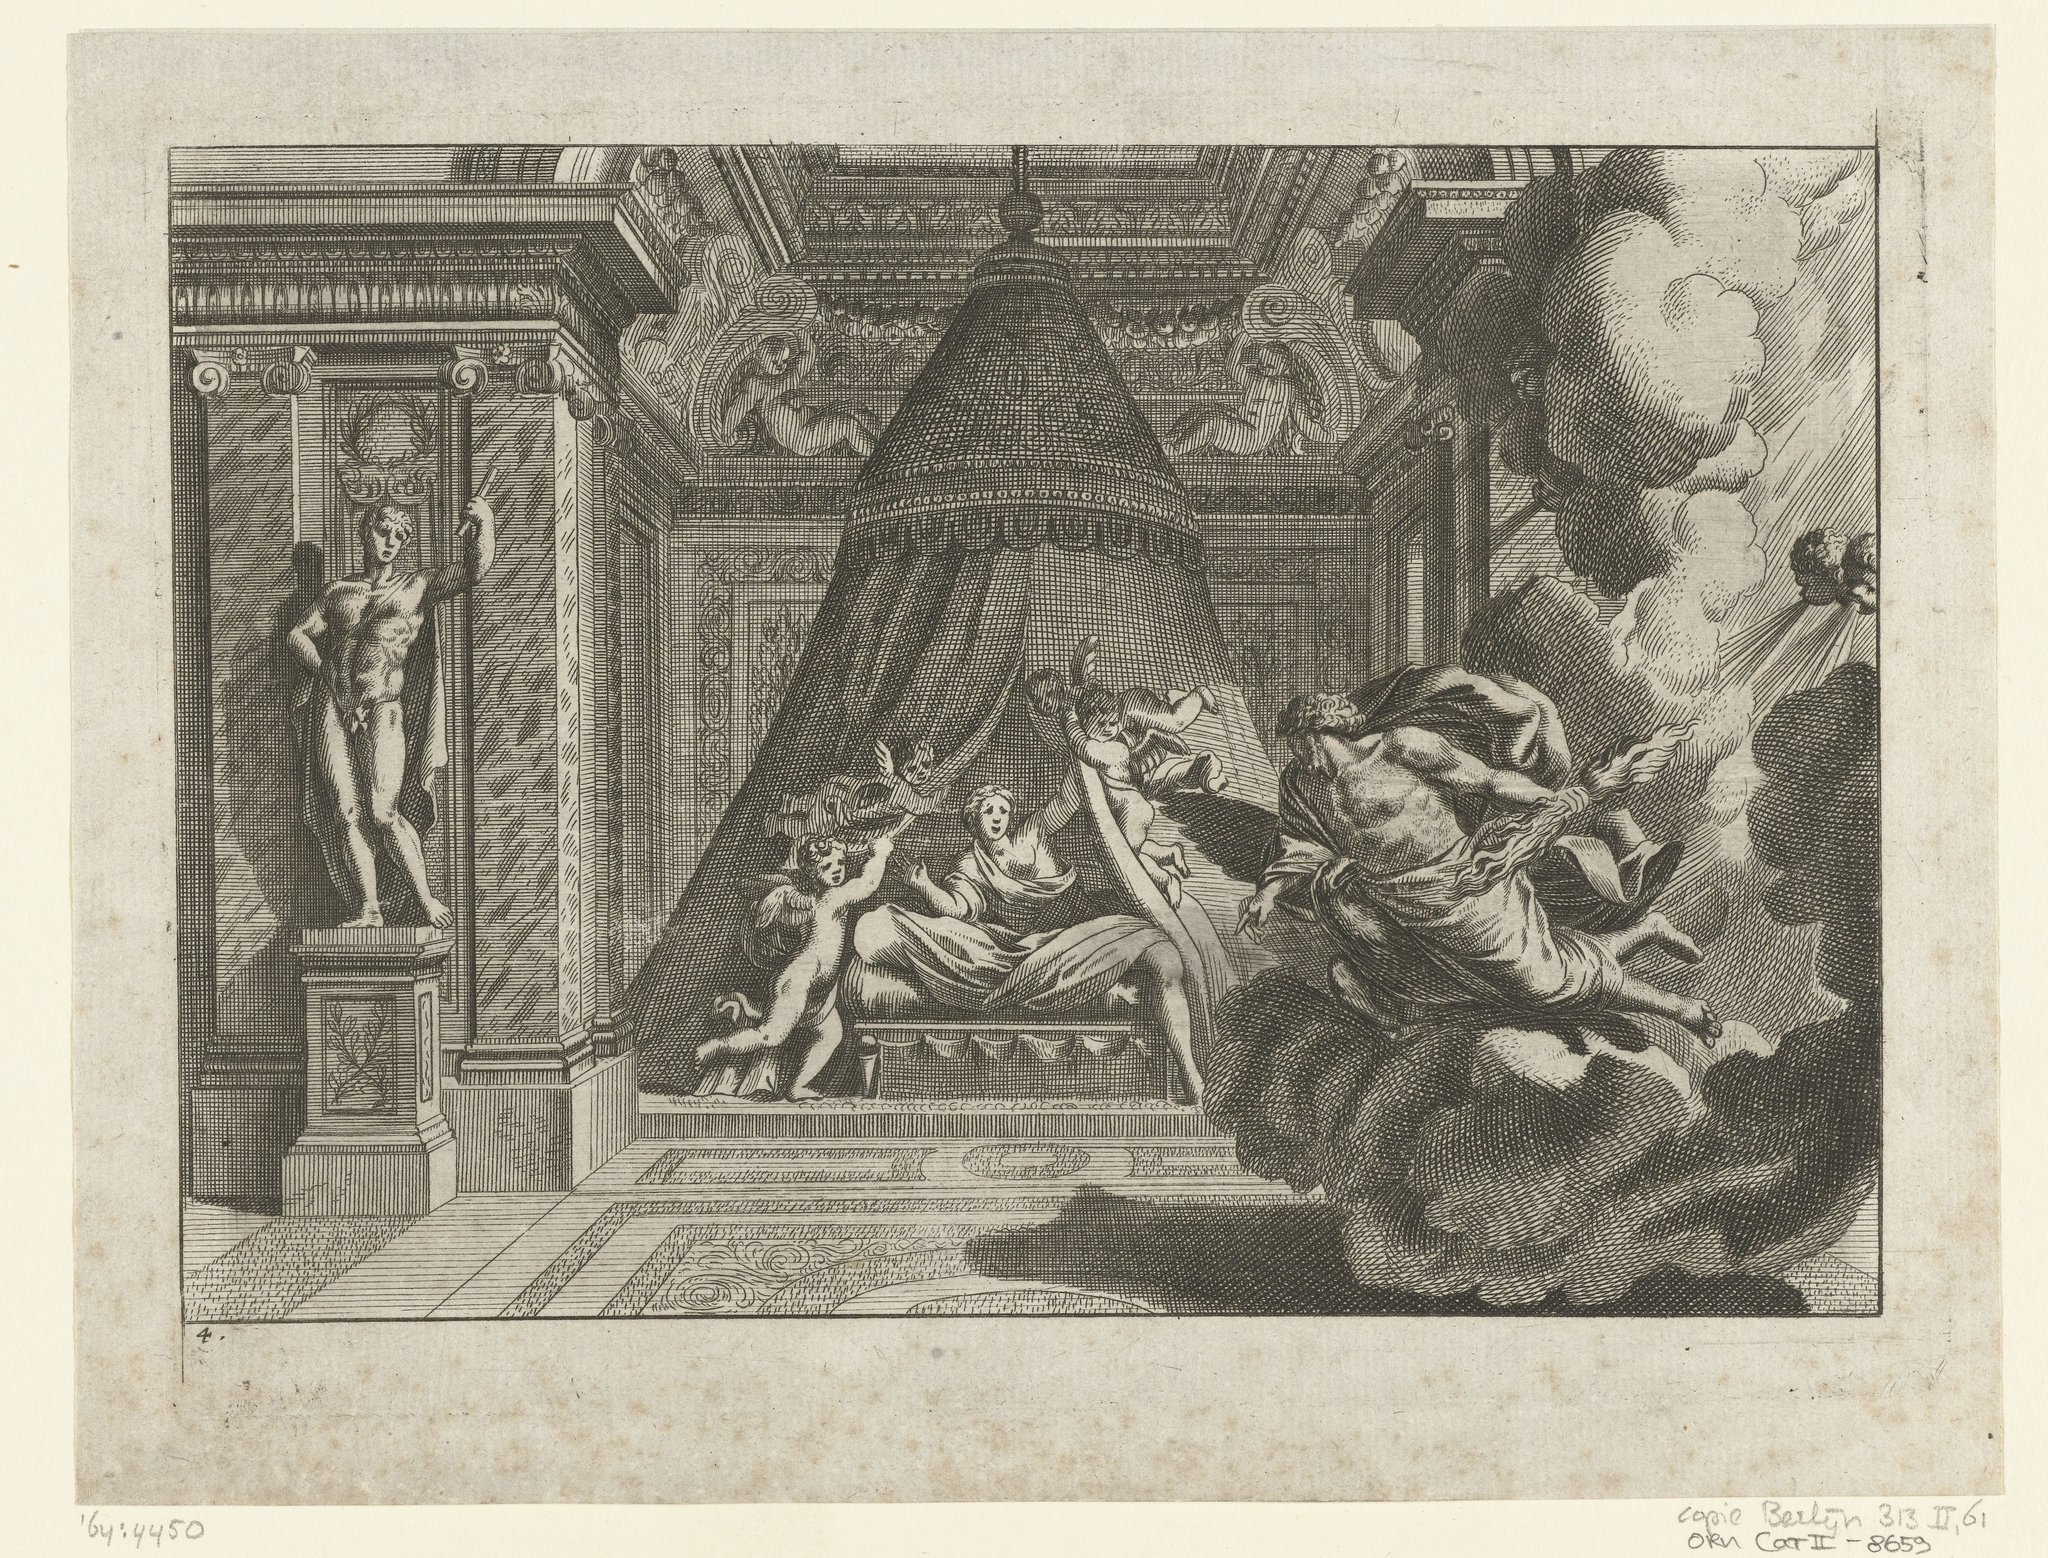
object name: ornament print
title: Alcoues a la Romaine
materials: paper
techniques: etching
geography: augsburg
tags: jupiter kills semele by coming to her with his lightning and thunderbolts